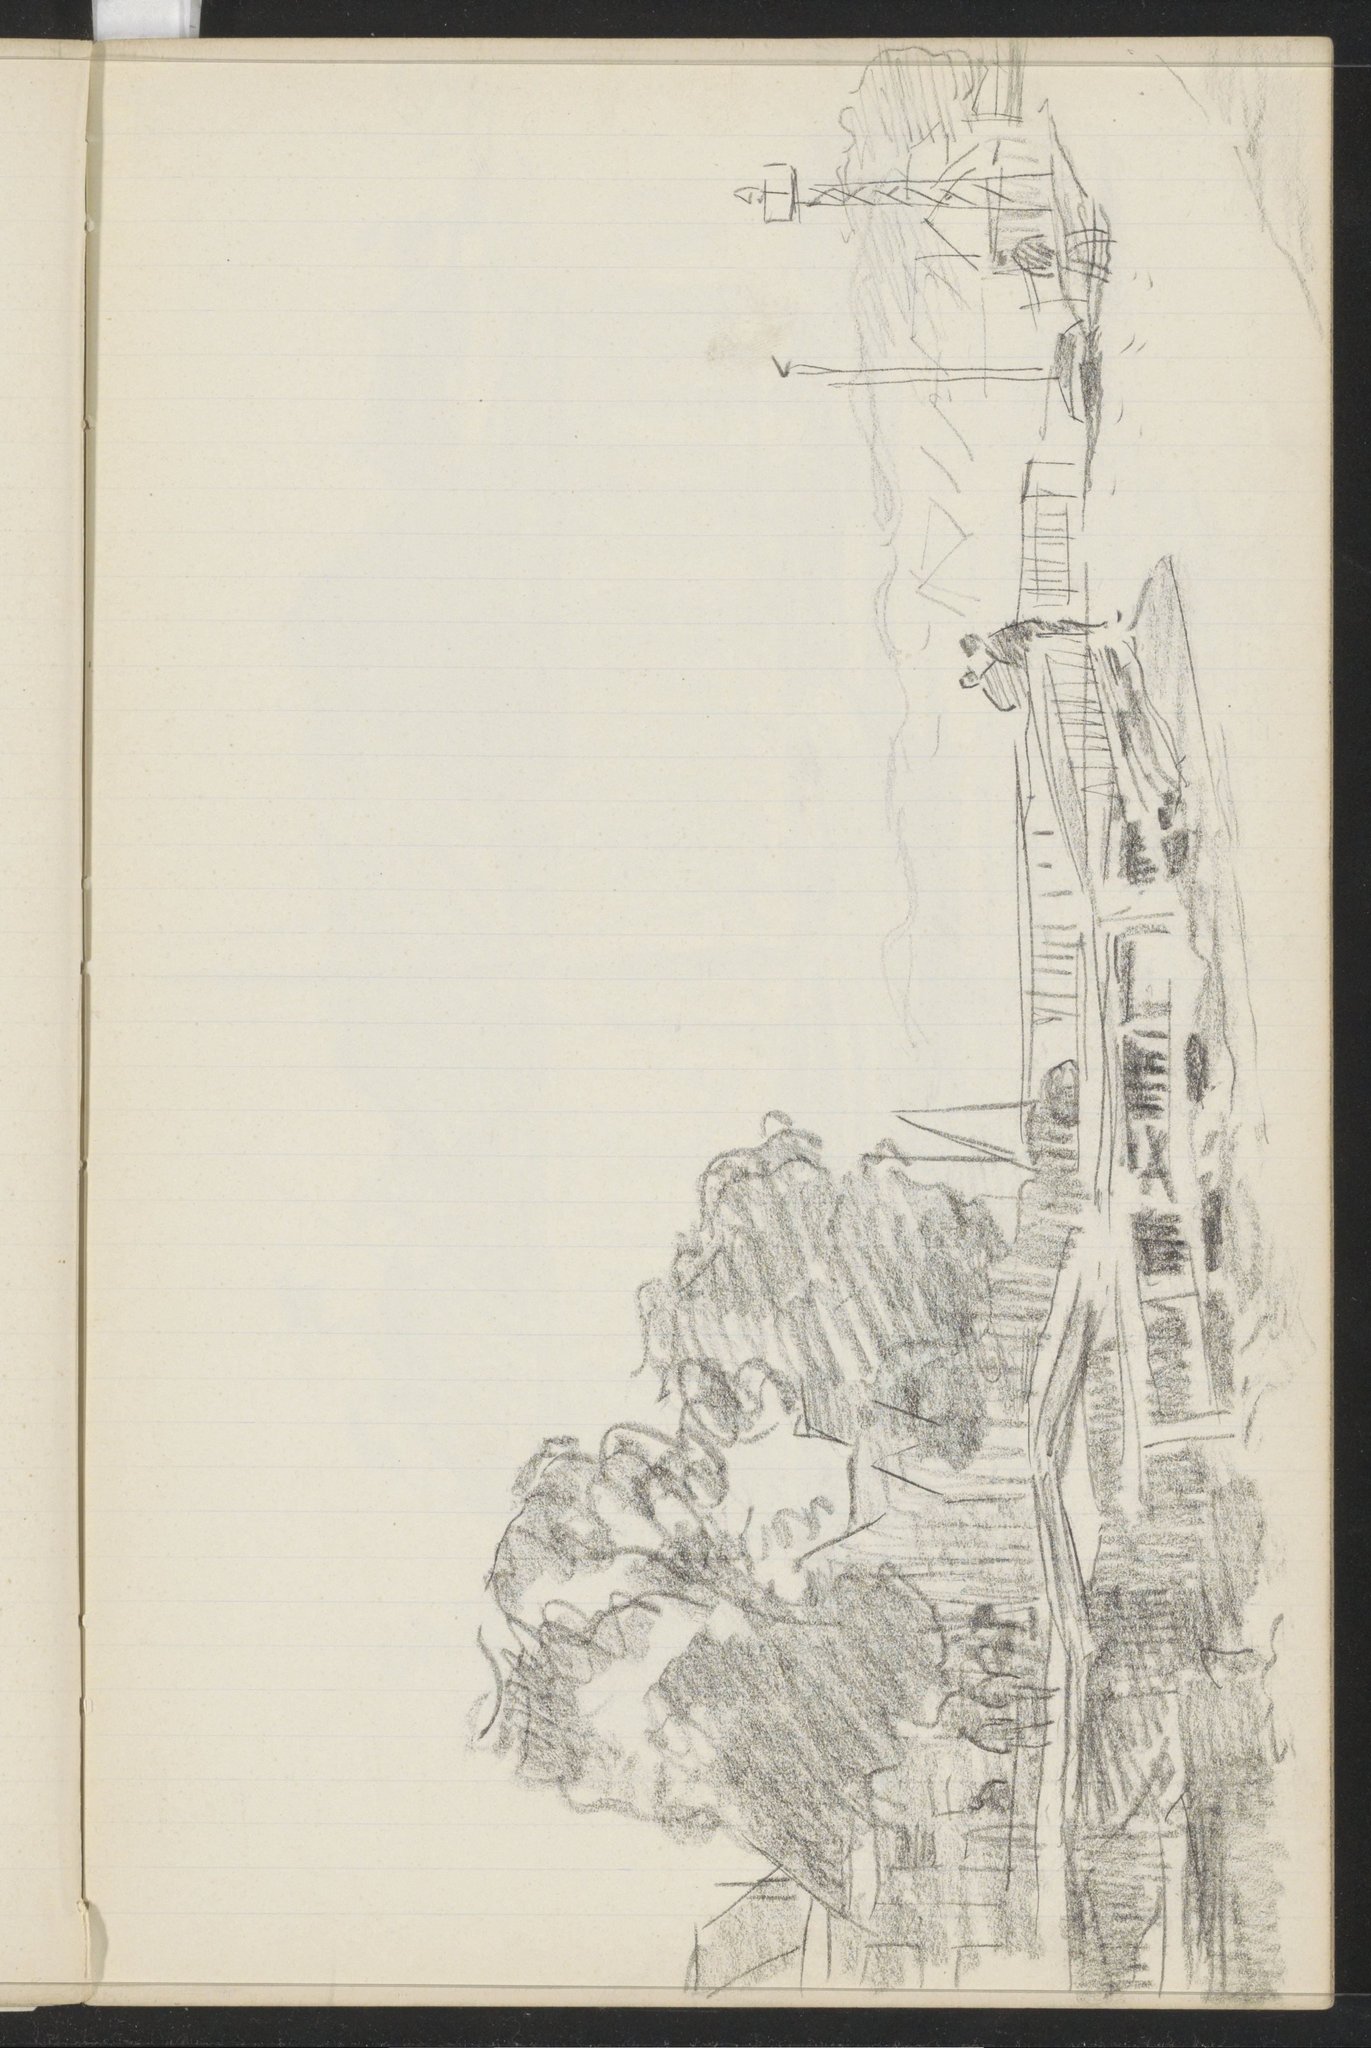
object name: sketchbook leaf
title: Brug over een kanaal in Enkhuizen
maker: willem bastiaan tholen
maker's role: draughtsman, painter, print maker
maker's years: 1860-1931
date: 1900-1931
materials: chalk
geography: enkhuizen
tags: bridge in city across river, canal, etc., street (+ city(-scape) with figures, staffage), enkhuizen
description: Blad 14 recto uit een schetsboek met 55 bladen.